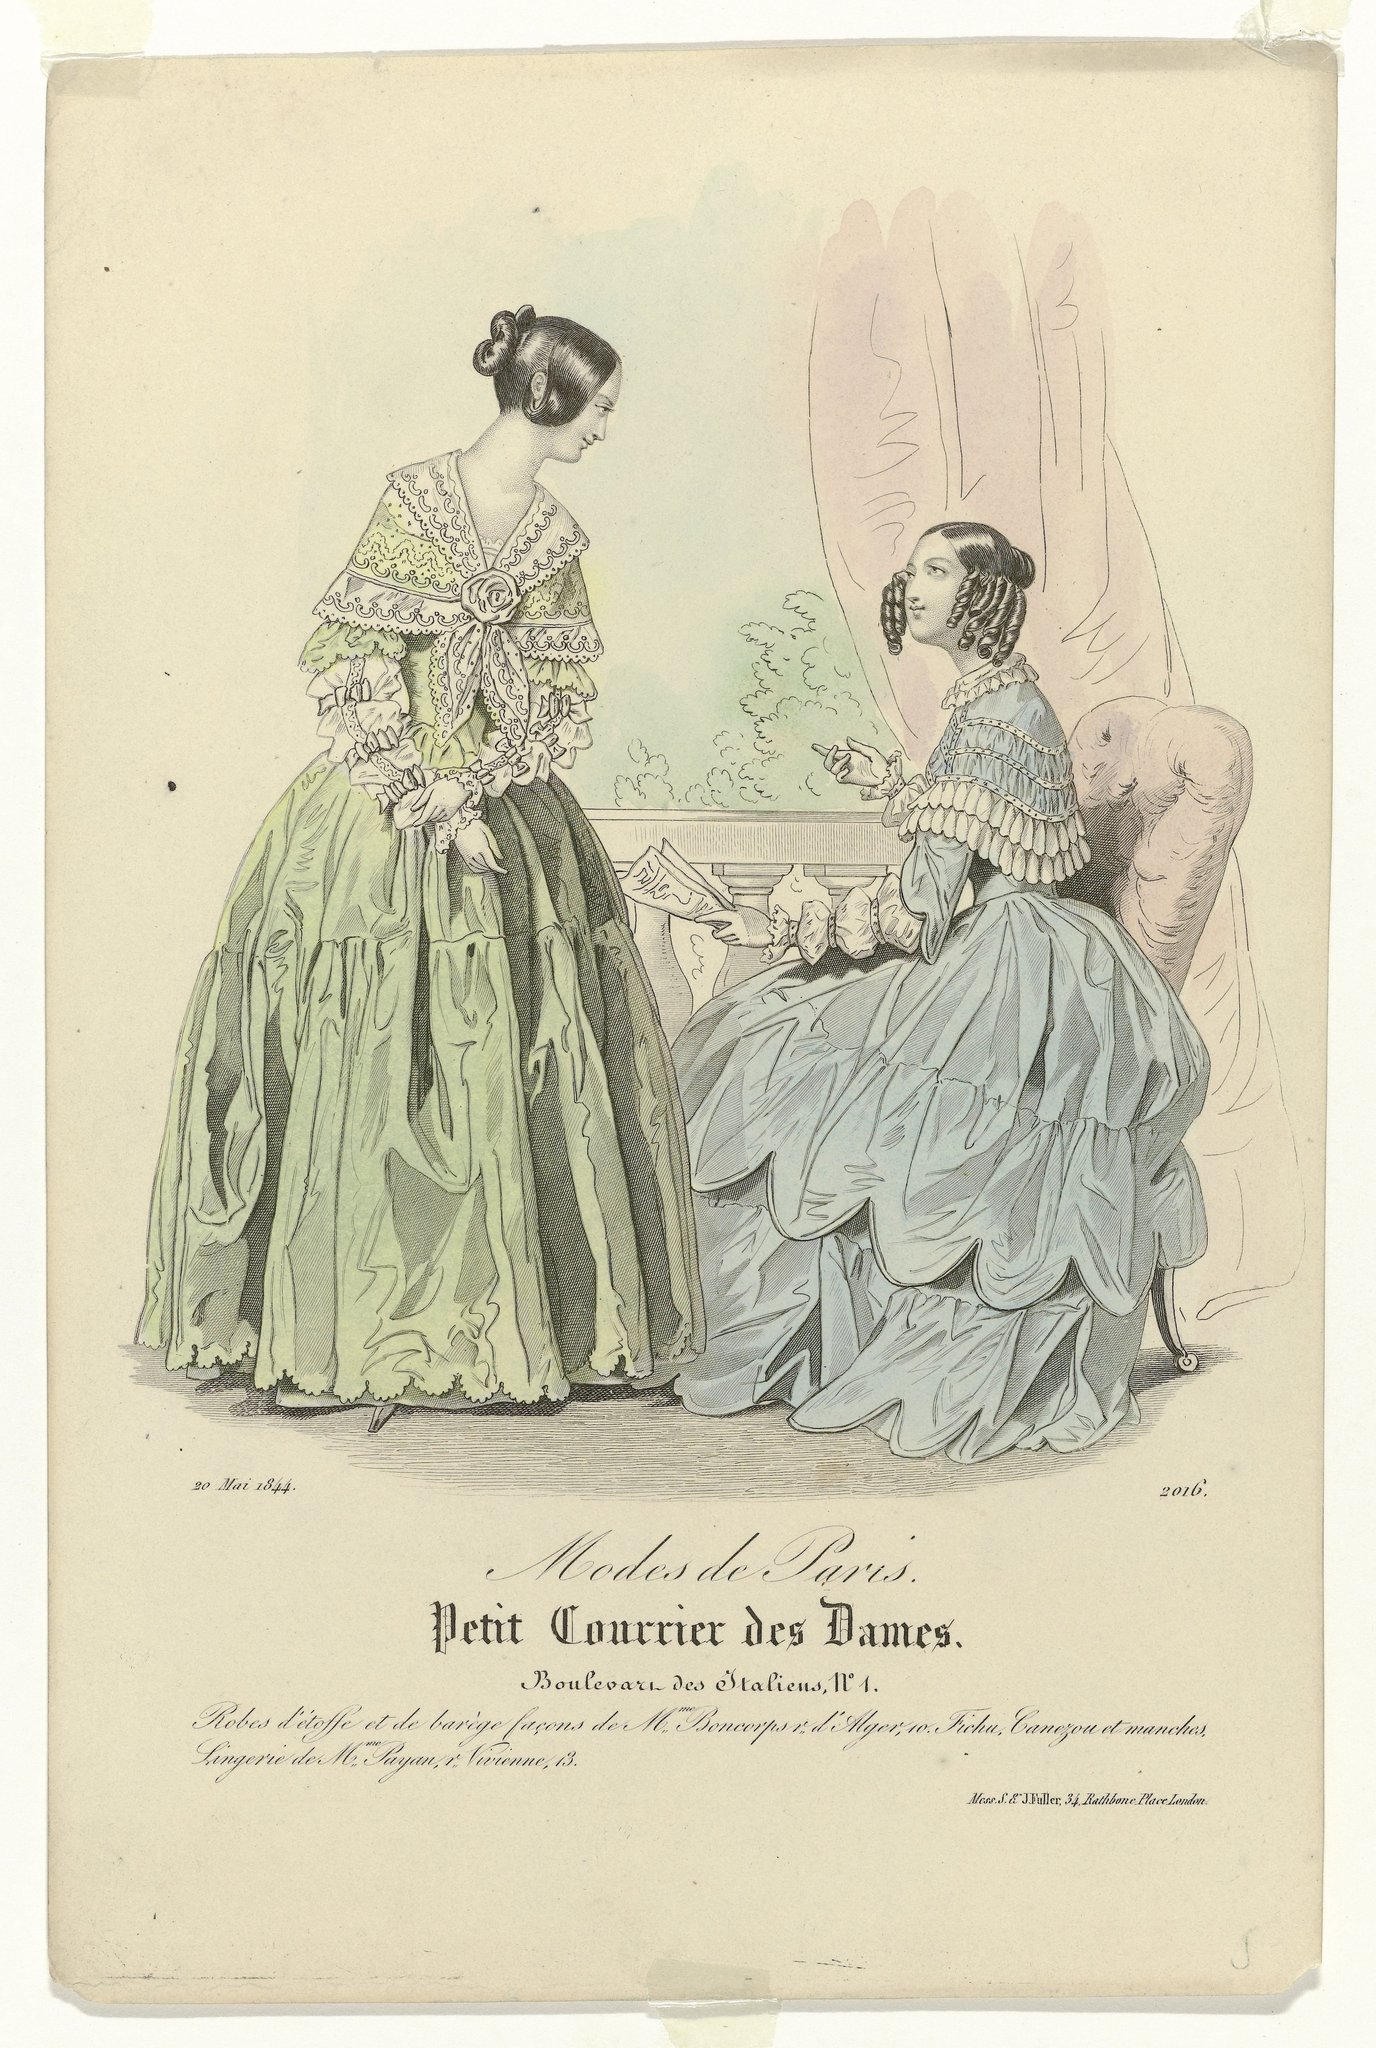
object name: fashion print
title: Petit Courrier des Dames, 20 mai 1844, No. 2016 : Robes d'étoff (...)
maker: Anonymous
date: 1844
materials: paper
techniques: engraving, hand coloring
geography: london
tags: fashion plates, dress, gown (+ women's clothes), piece of clothing covering the breast or décolleté (fichu) (+ women's clothes)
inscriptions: caption: ‘Robes d'étoffe et de barège façons de M"me Boncorps r"d'Alger, 10. Fichu, Canezou et manches, Lingerie des M"me Payan, r"Vivienne, 13.’, address: ‘Boulevart des Italiens, No 1. / Mess. S. & J. Fuller, 34, Rathbone Place, London.’, title: ‘Modes de Paris. / Petit Courrier des Dames.’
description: Twee vrouwen bij een balustrade. Volgens het onderschrift: japonnen van stof en 'barège', 'façons de Mmh Boncorps'. Fichu, 'canezou' en mamelukkenmouwen. 'Lingerie' van Payan. Prent uit het modetijdschrift Petit Courrier des Dames (1821-1868).